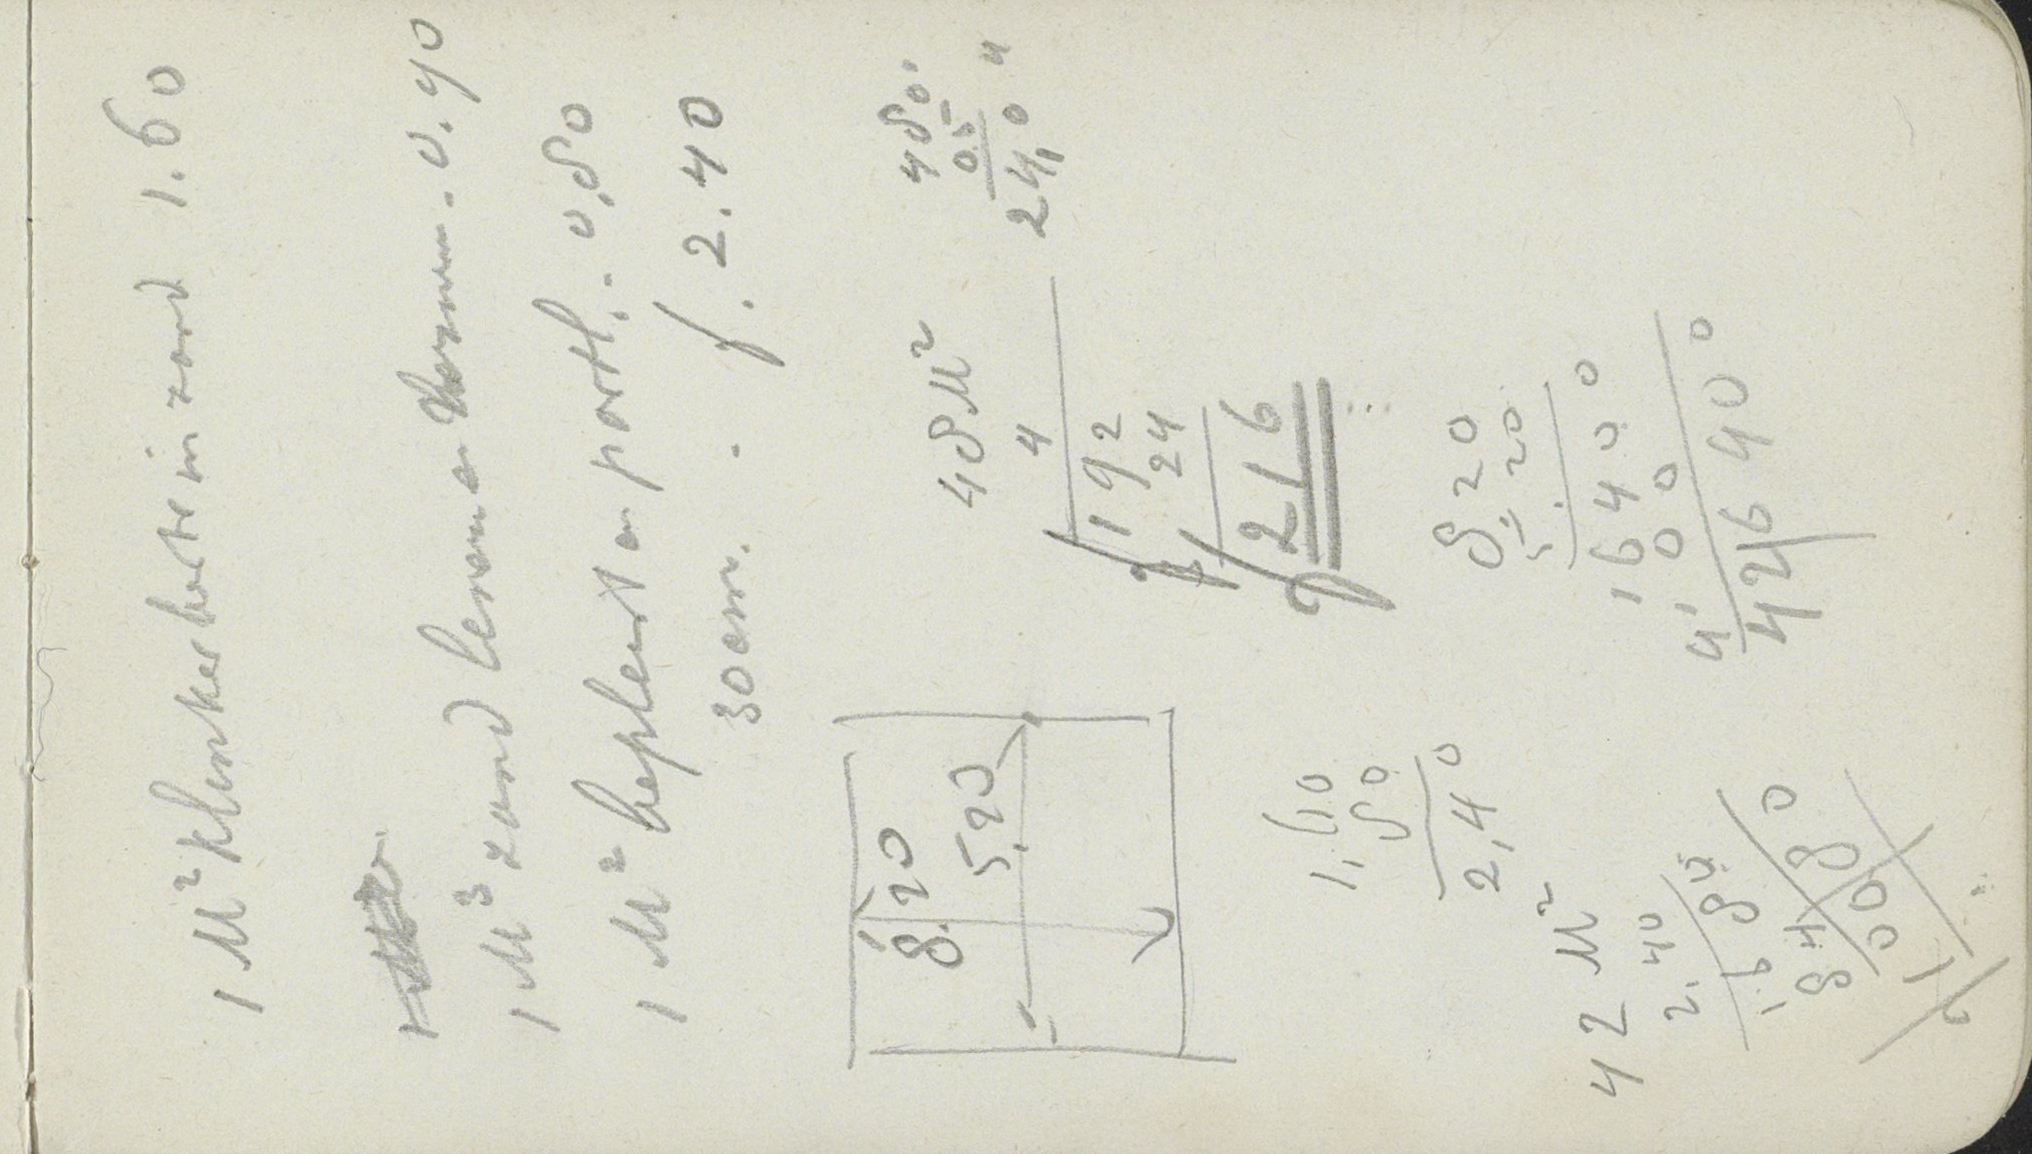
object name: sketchbook leaf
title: Berekeningen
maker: carel adolph lion cachet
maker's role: draughtsman, print maker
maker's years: 1864-1945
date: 1905-1906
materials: paper, pencil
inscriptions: annotation: ‘[...]’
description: Blad 3 recto uit een schetsboek met 34 bladen.